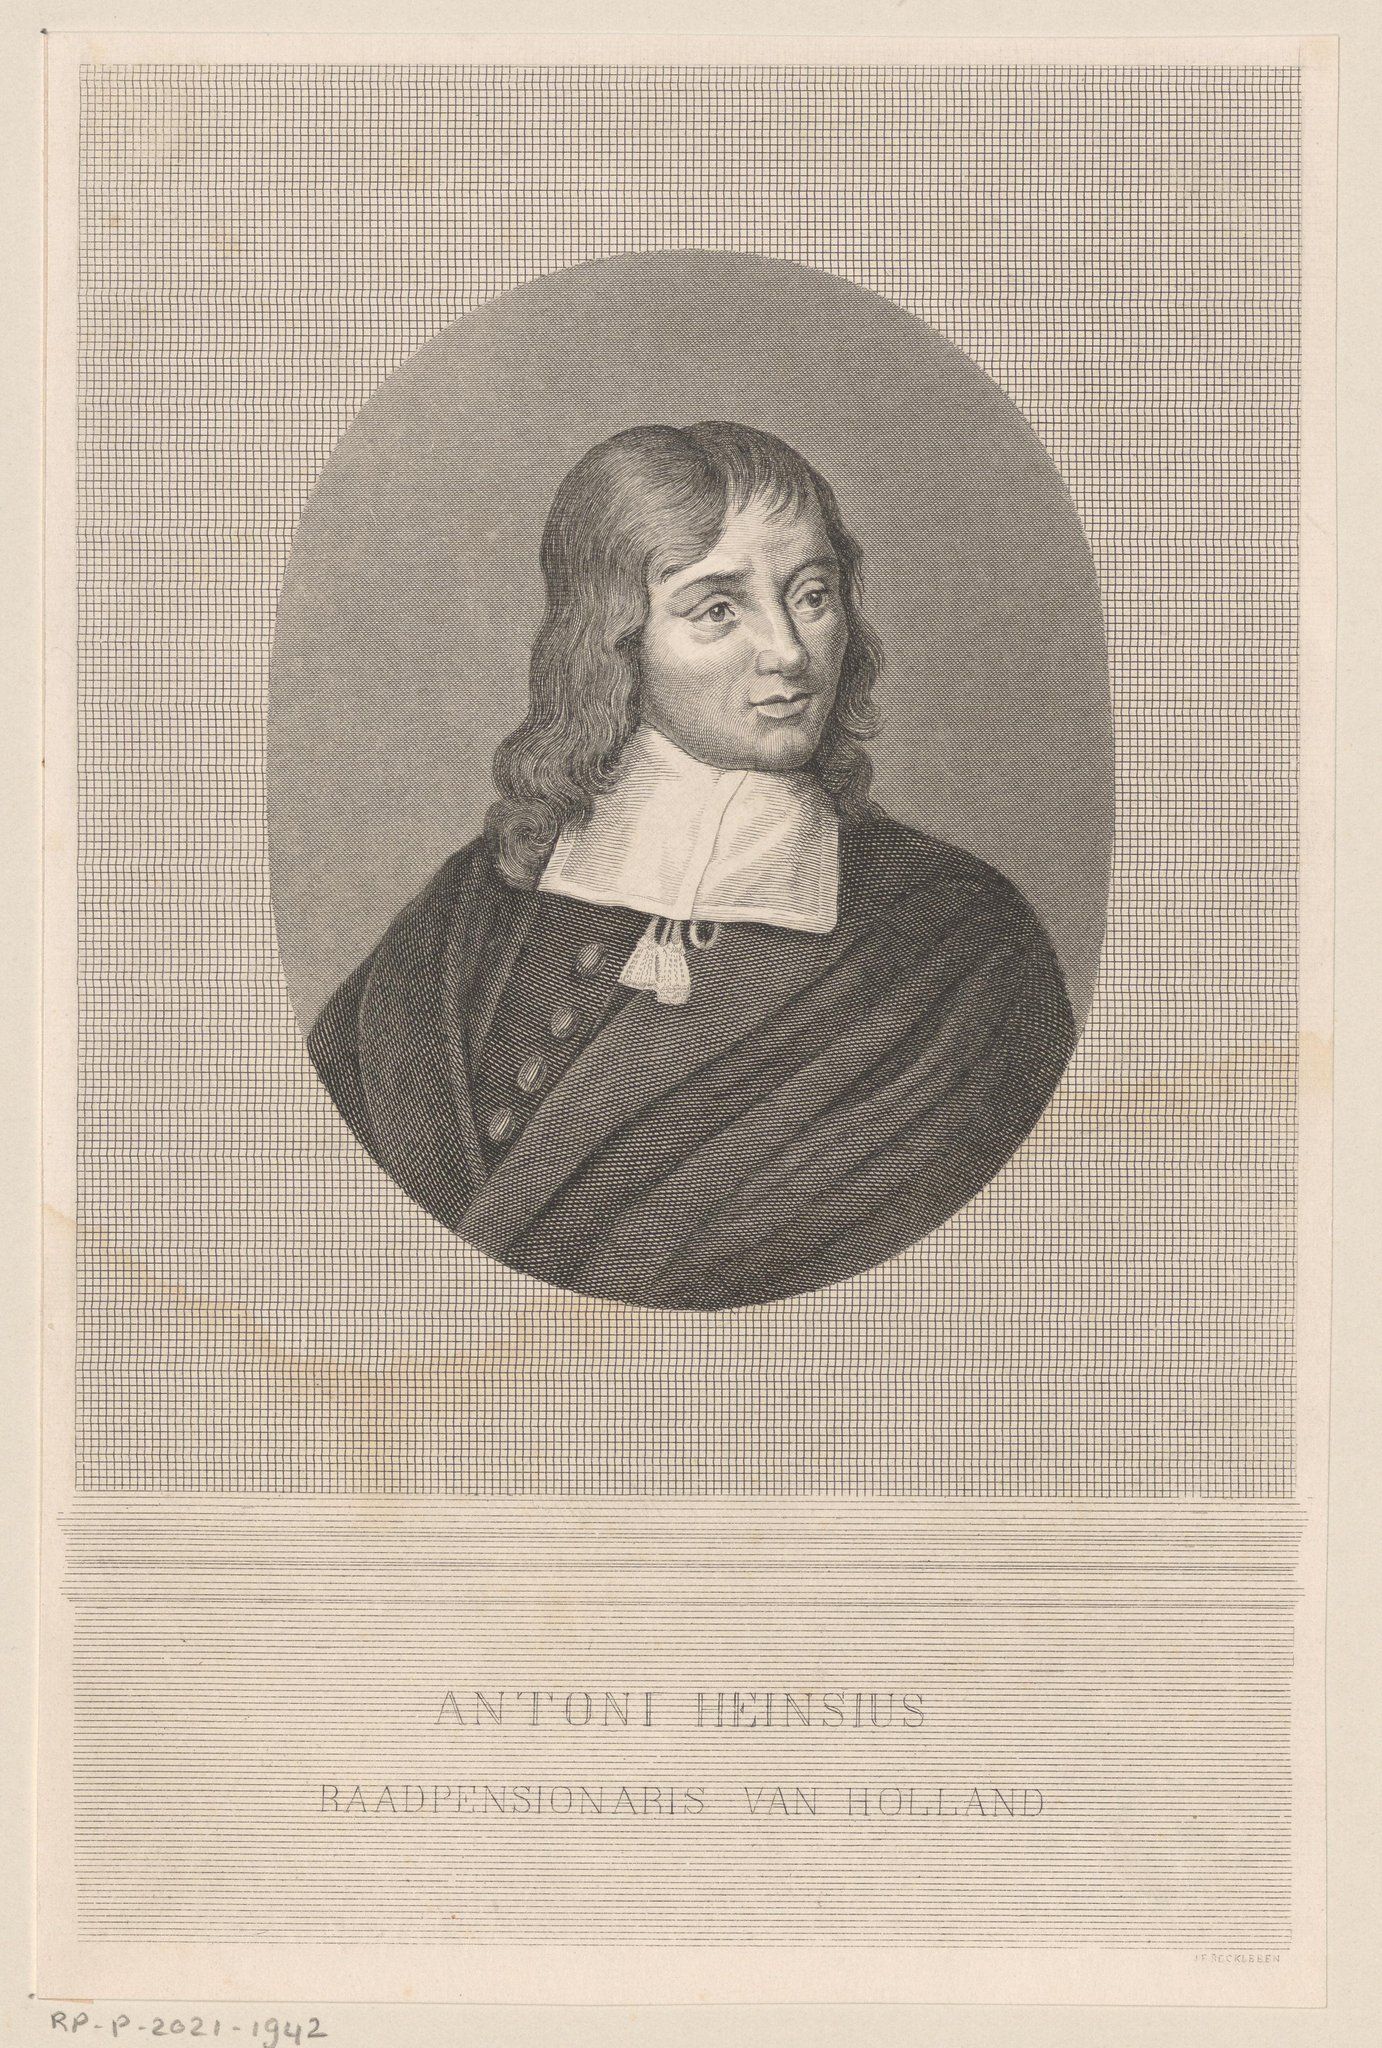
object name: book illustration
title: Portret van Anthonie Heinsius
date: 1879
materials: paper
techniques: engraving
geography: amsterdam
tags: the hague, anthonie heinsius, historical persons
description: Prent uit: Arend, Johannes Pieter. Algemeene geschiedenis des vaderlands van de vroegste tijden tot op heden. Haarlem: Jan de Haan, 1879, dl. 4-2.